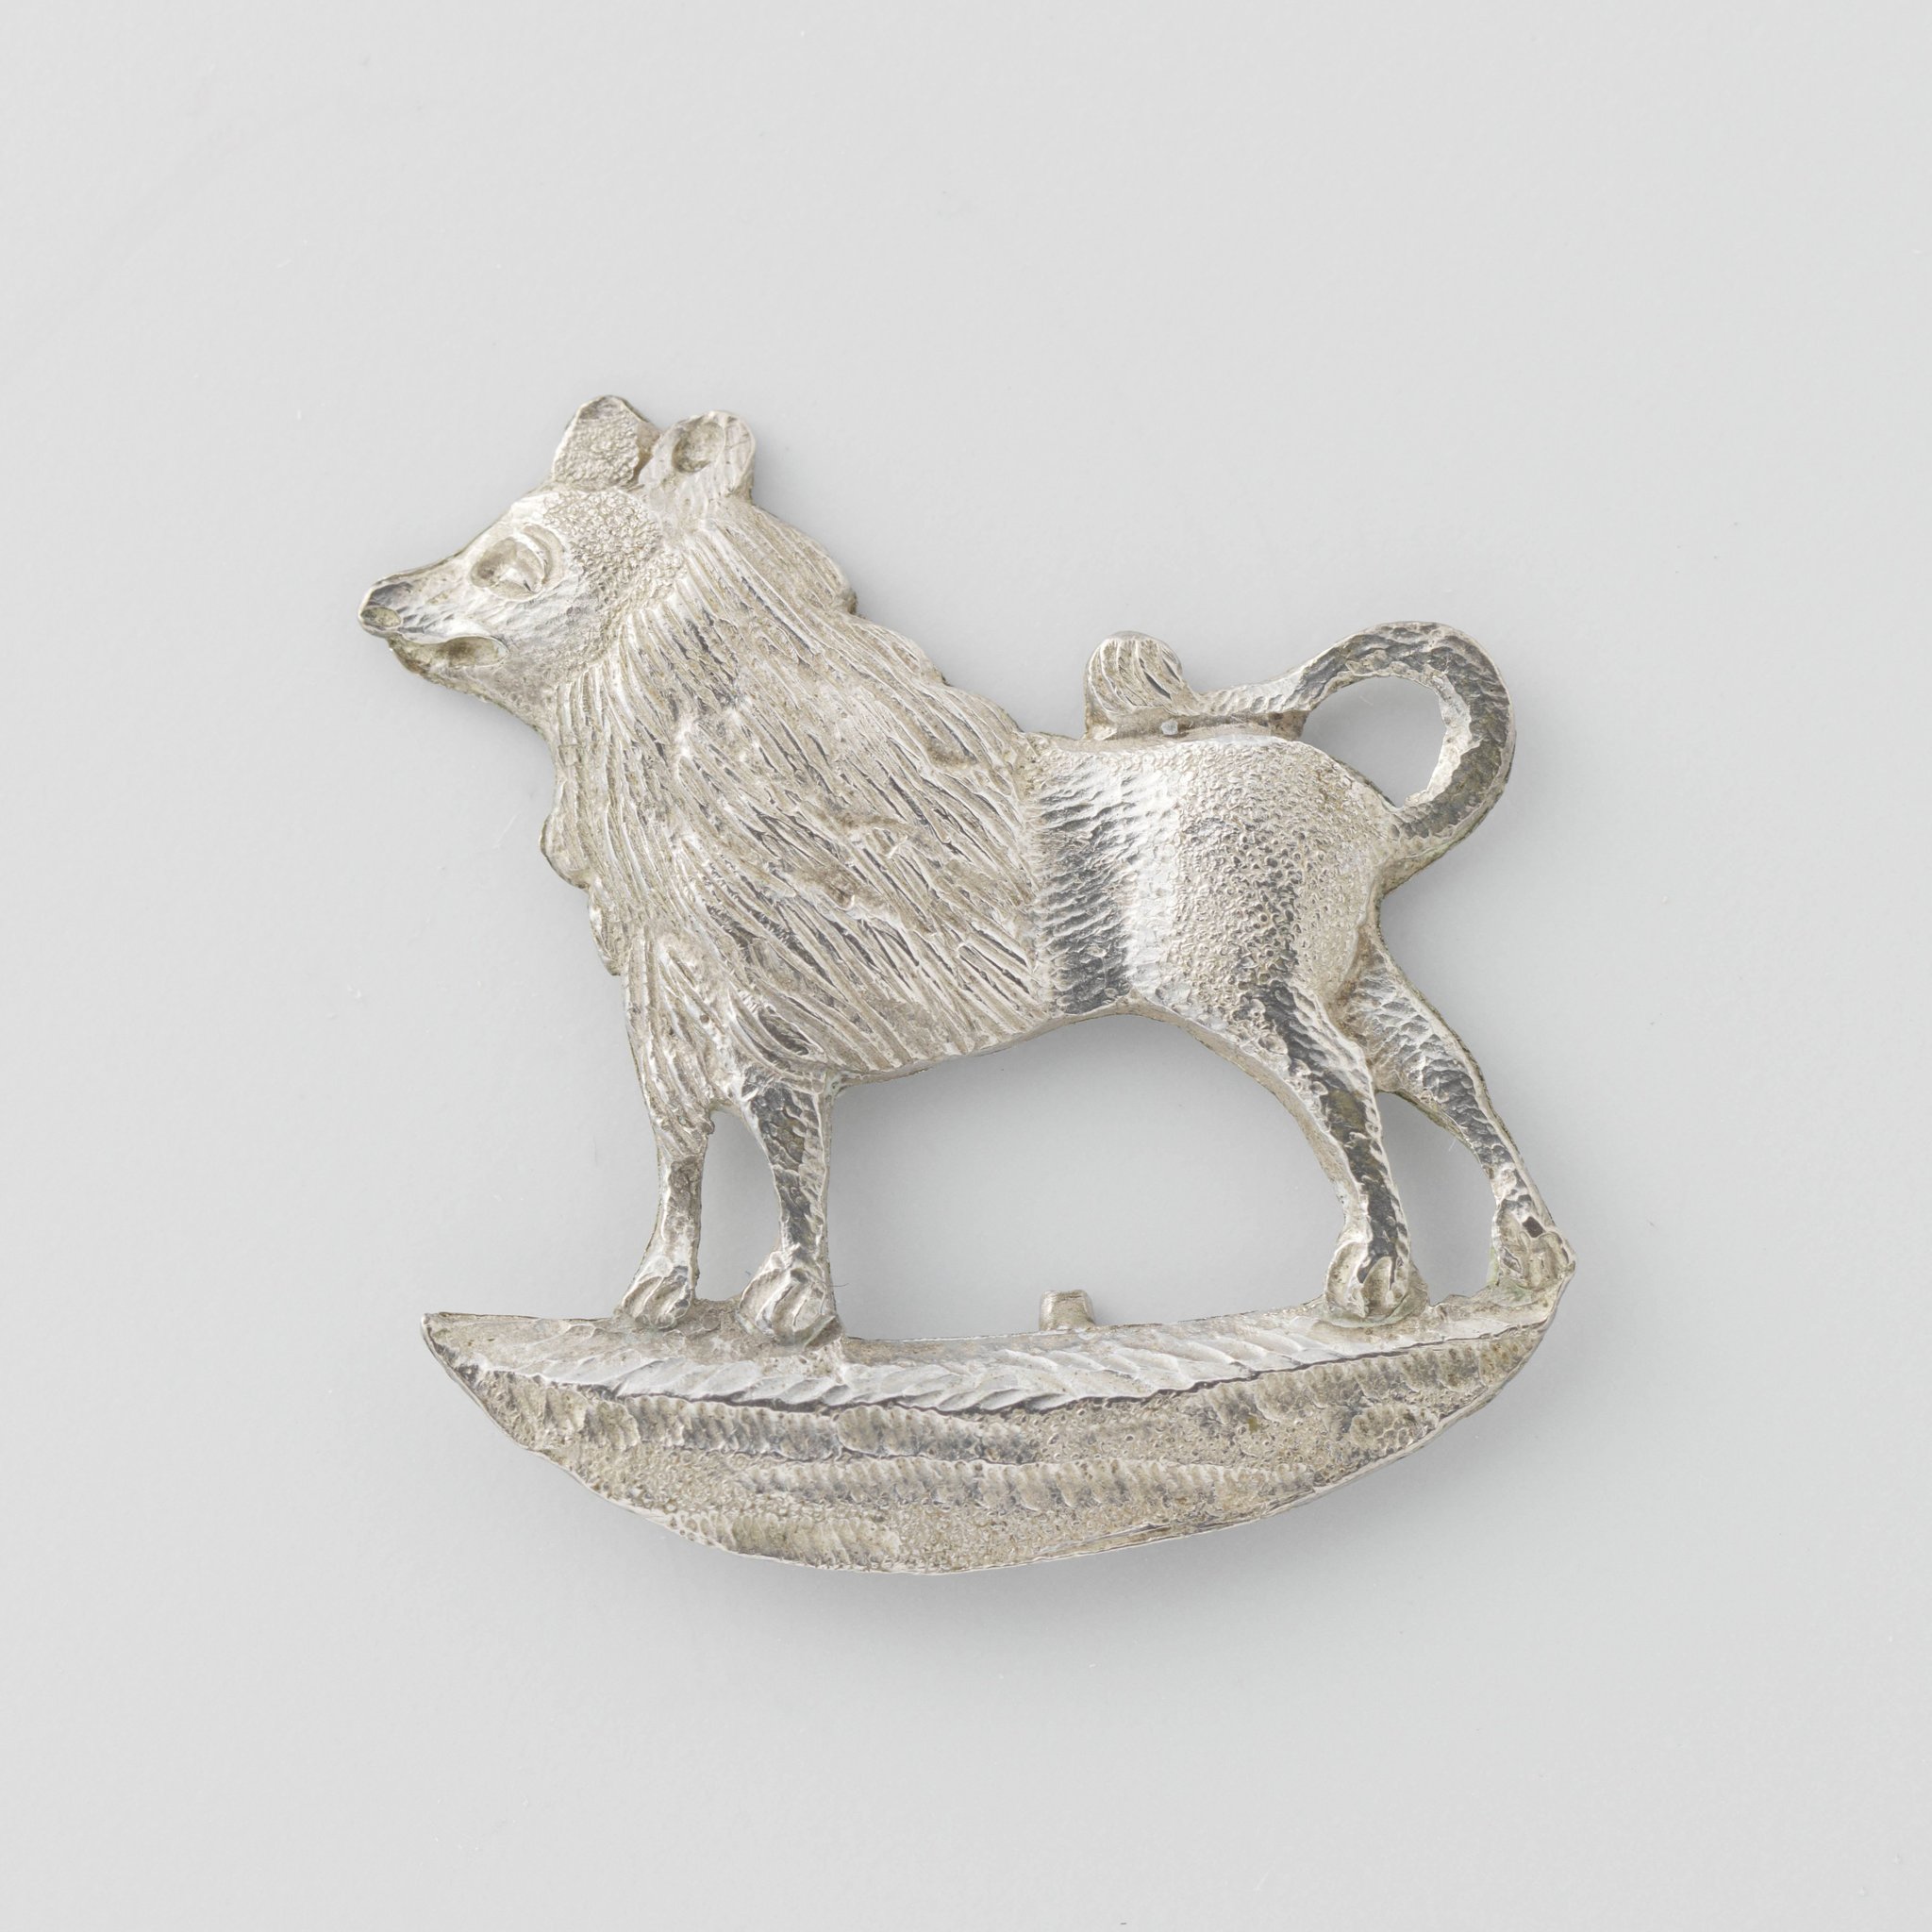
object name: plaque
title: Keeshondje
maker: Anonymous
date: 1784-1787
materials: silver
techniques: embroidery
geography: netherlands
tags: dog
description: Badge with spitz dog.